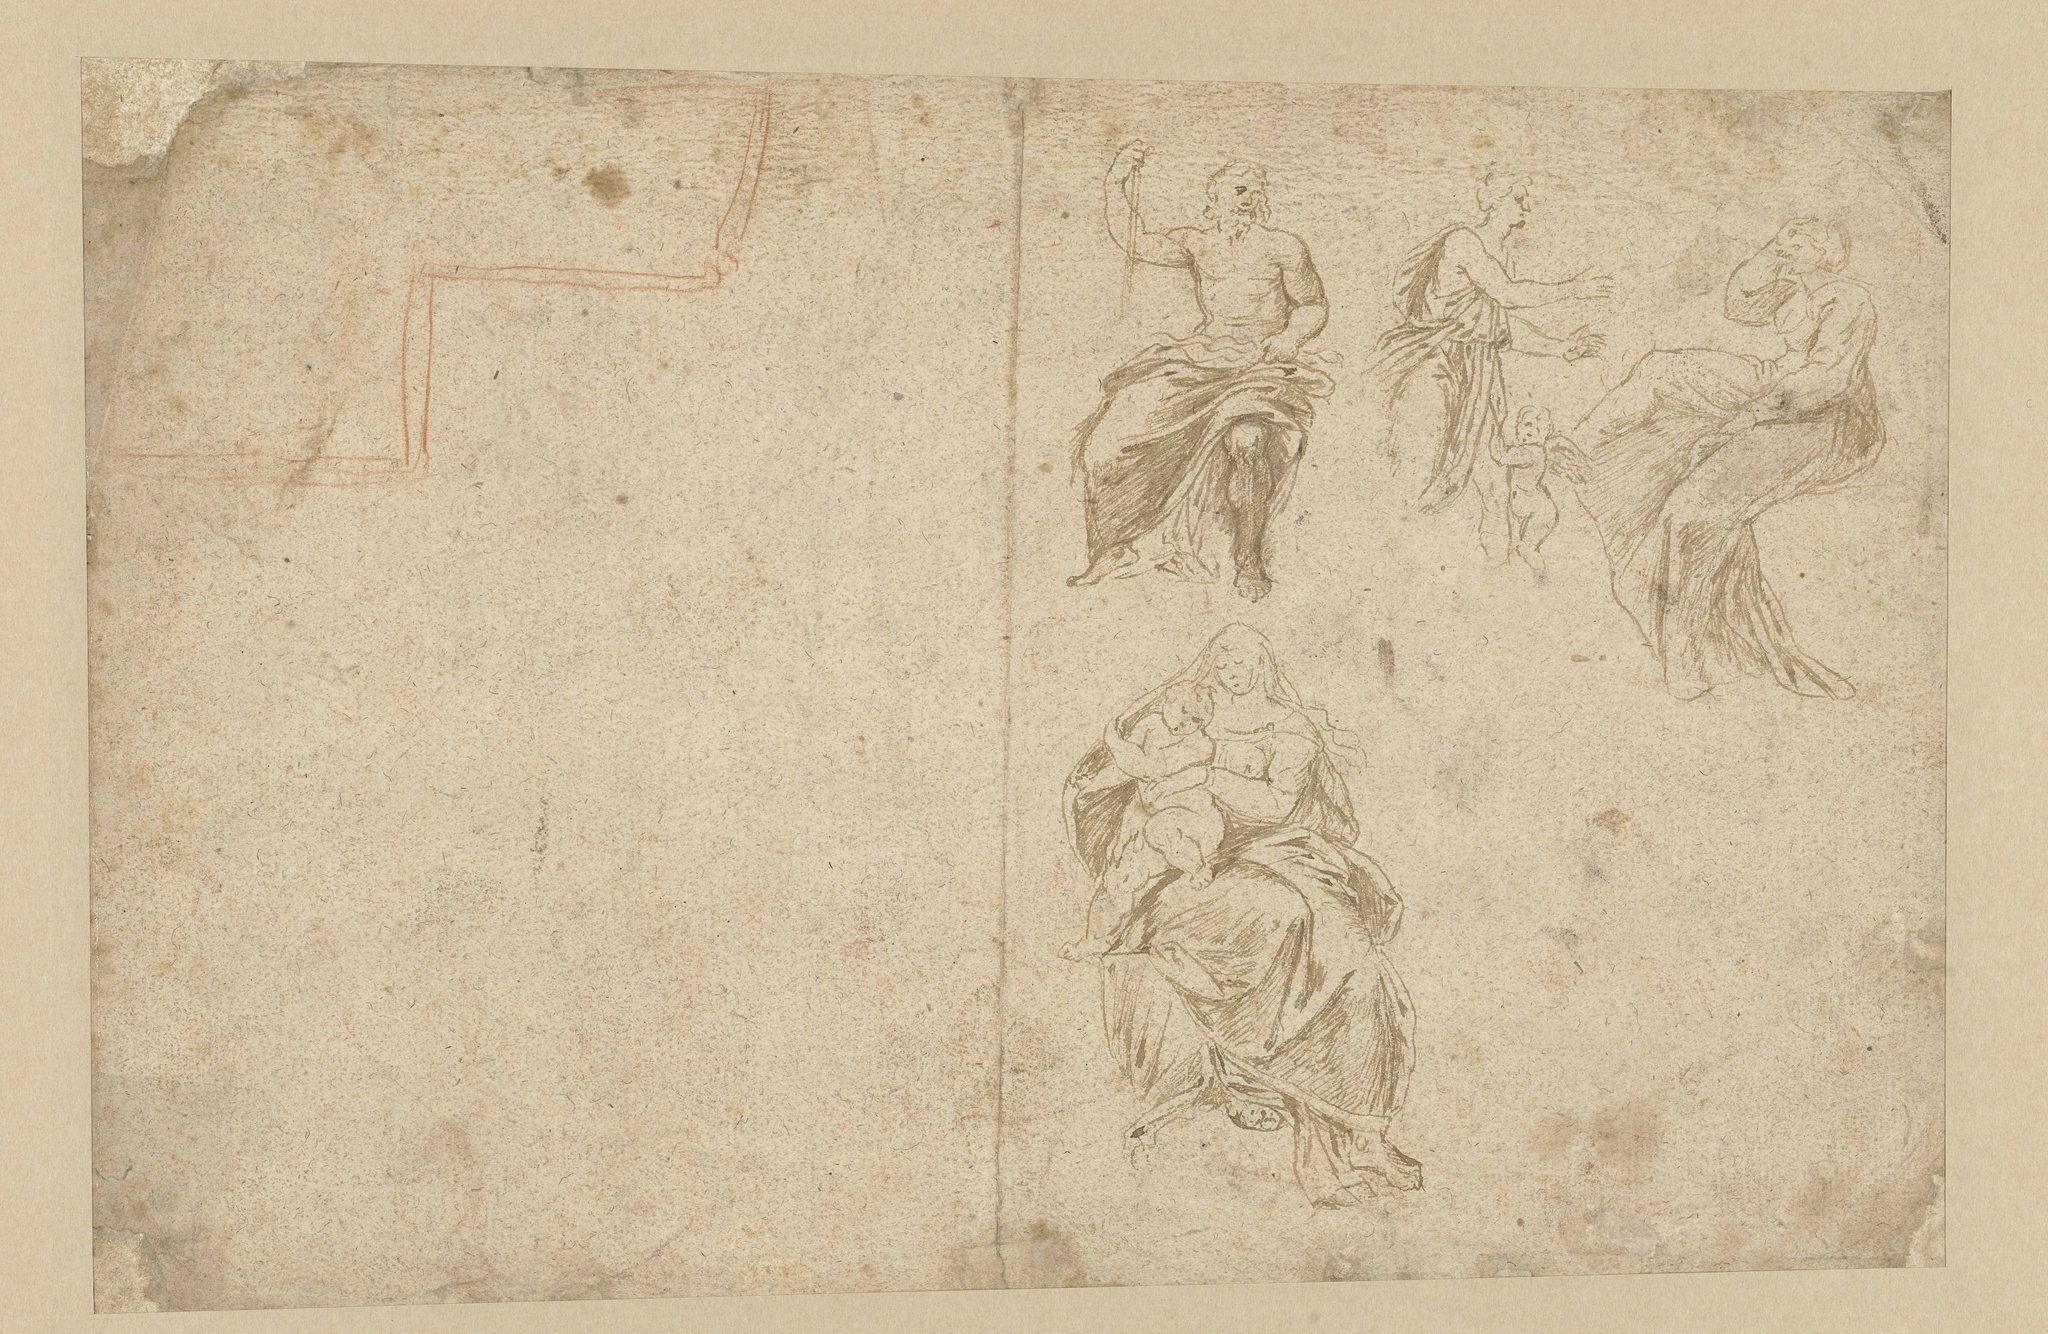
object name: drawing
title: Motieven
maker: Anonymous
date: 1500-1599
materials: ink, paper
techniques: pen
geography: low countries